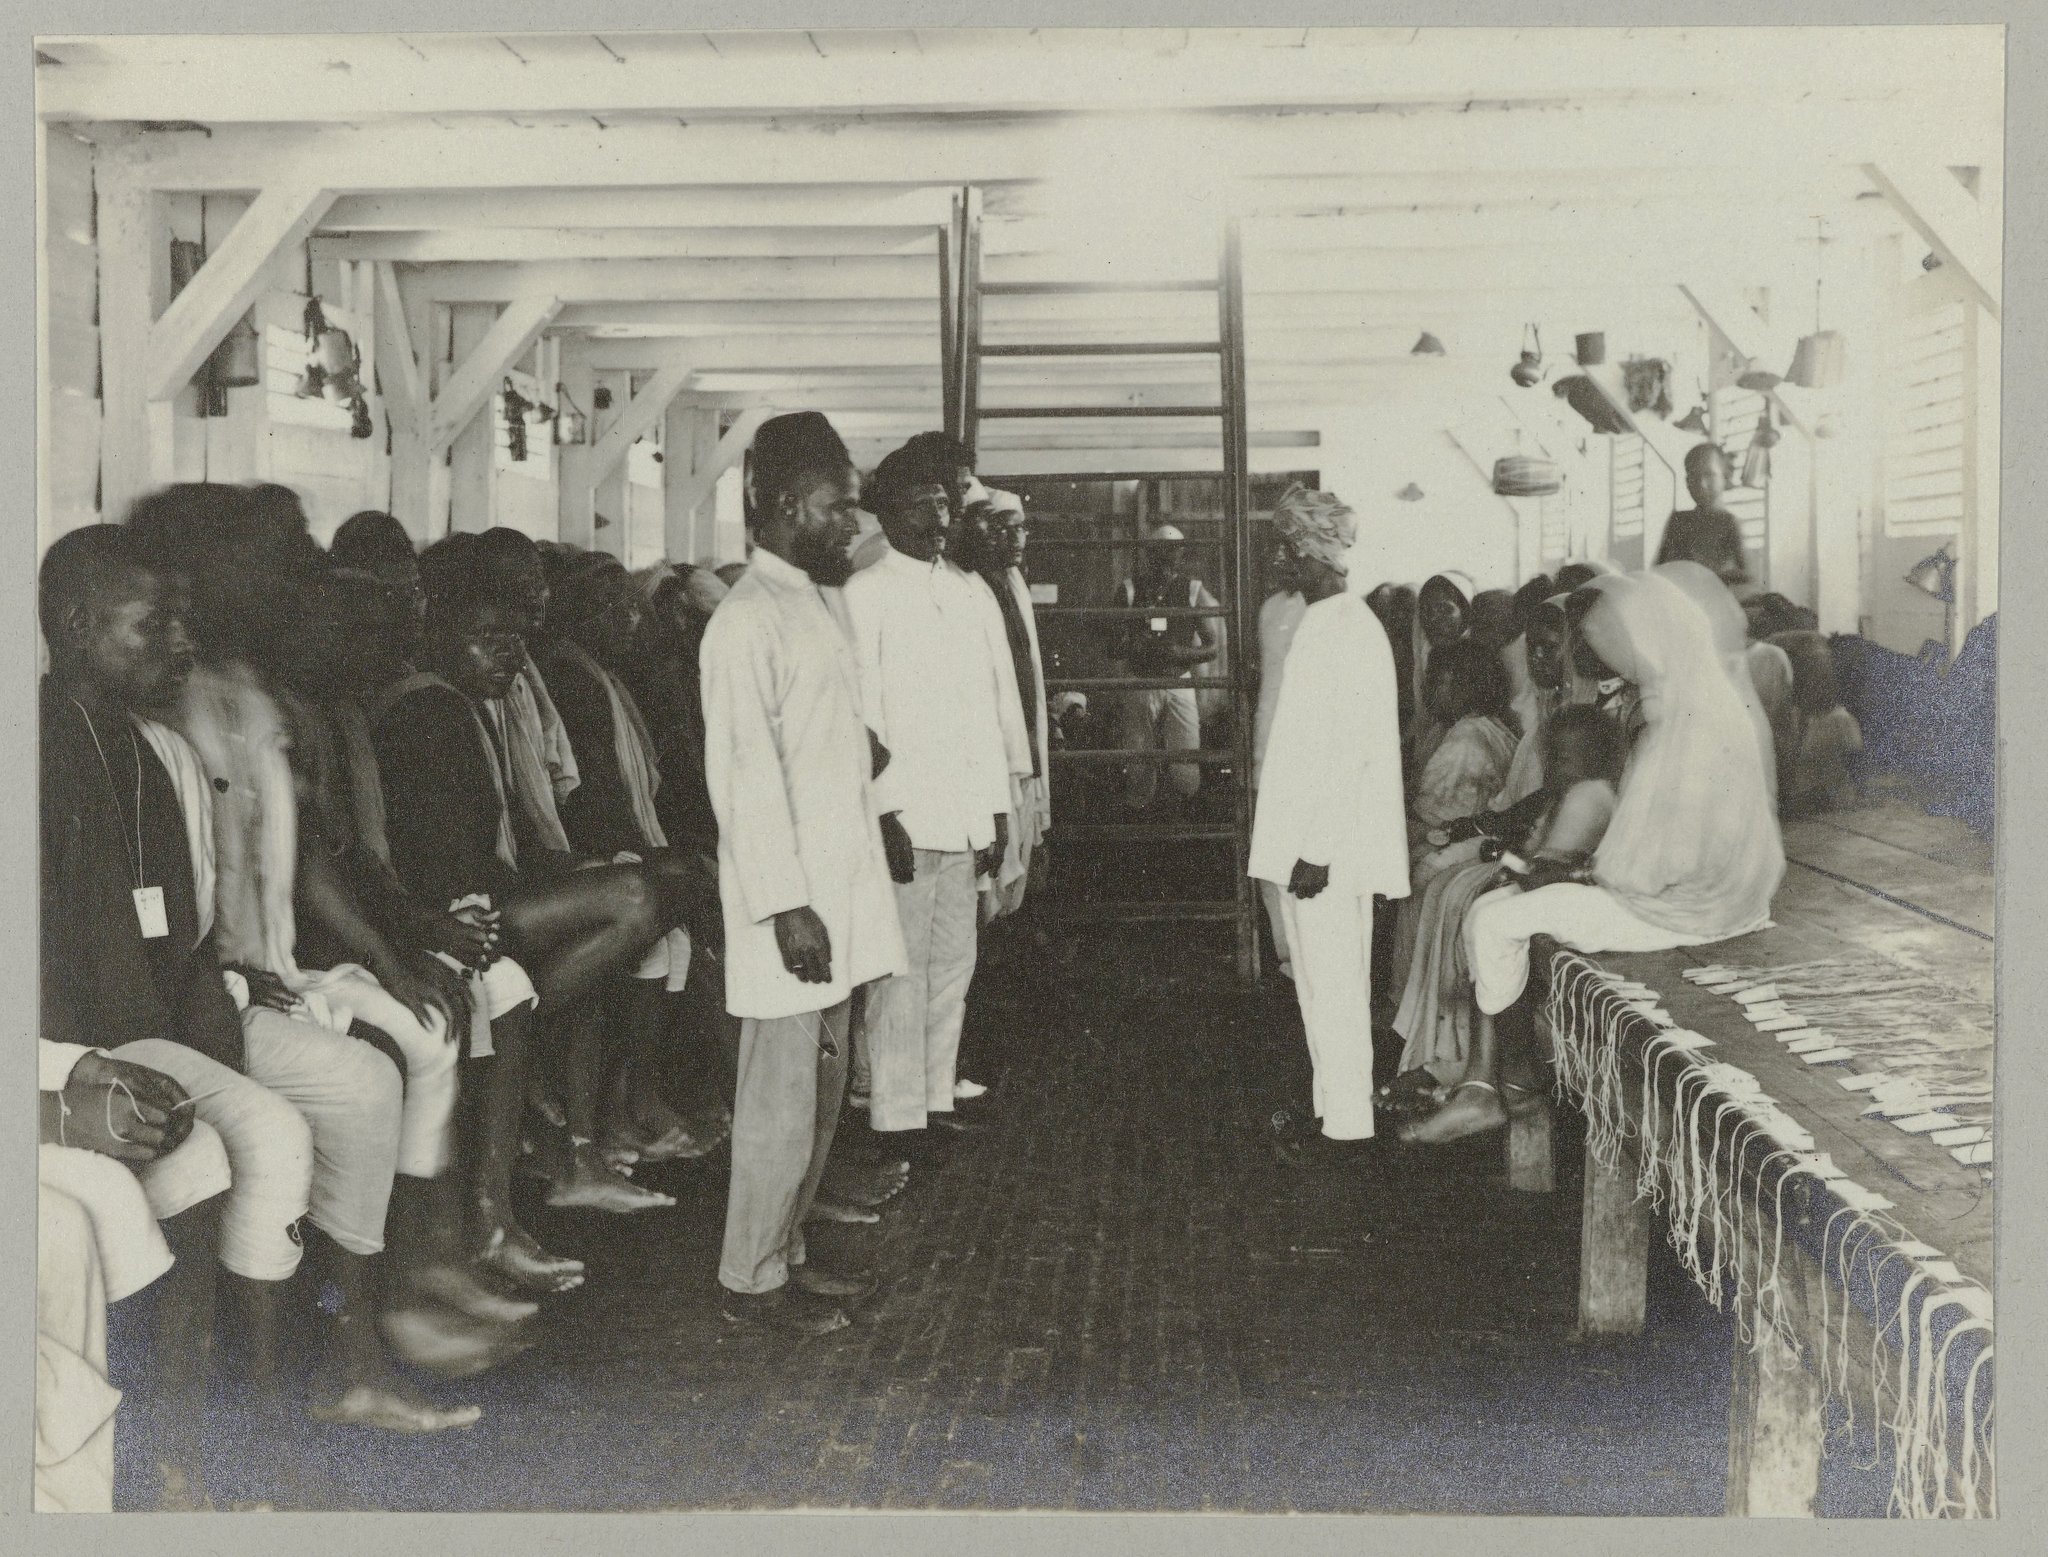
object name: photograph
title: In het koeliedepôt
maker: hendrik doijer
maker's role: engineer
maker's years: 1863-1925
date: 1903-1910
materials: photographic support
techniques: gelatin silver print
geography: suriname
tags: working class, labourers, suriname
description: Contractarbeiders uit Brits-Indië in één van de barakken in het zgn. ‘koeliedepot’, het centrale verzamelpunt voor immigranten in Paramaribo. Onderdeel van het fotoalbum Souvenir de Voyage (deel 5), over het leven van de familie Doijer in en rond de plantage Ma Retraite in Suriname in de jaren 1903-1910.